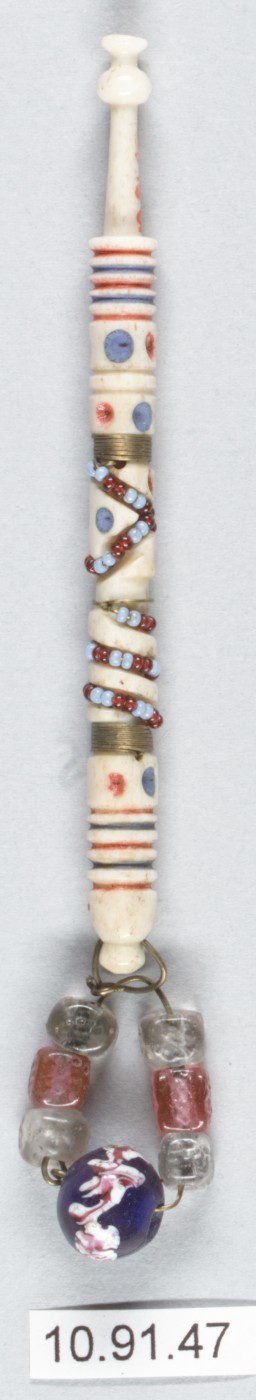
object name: bobbin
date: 1801-1900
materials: bone, metal